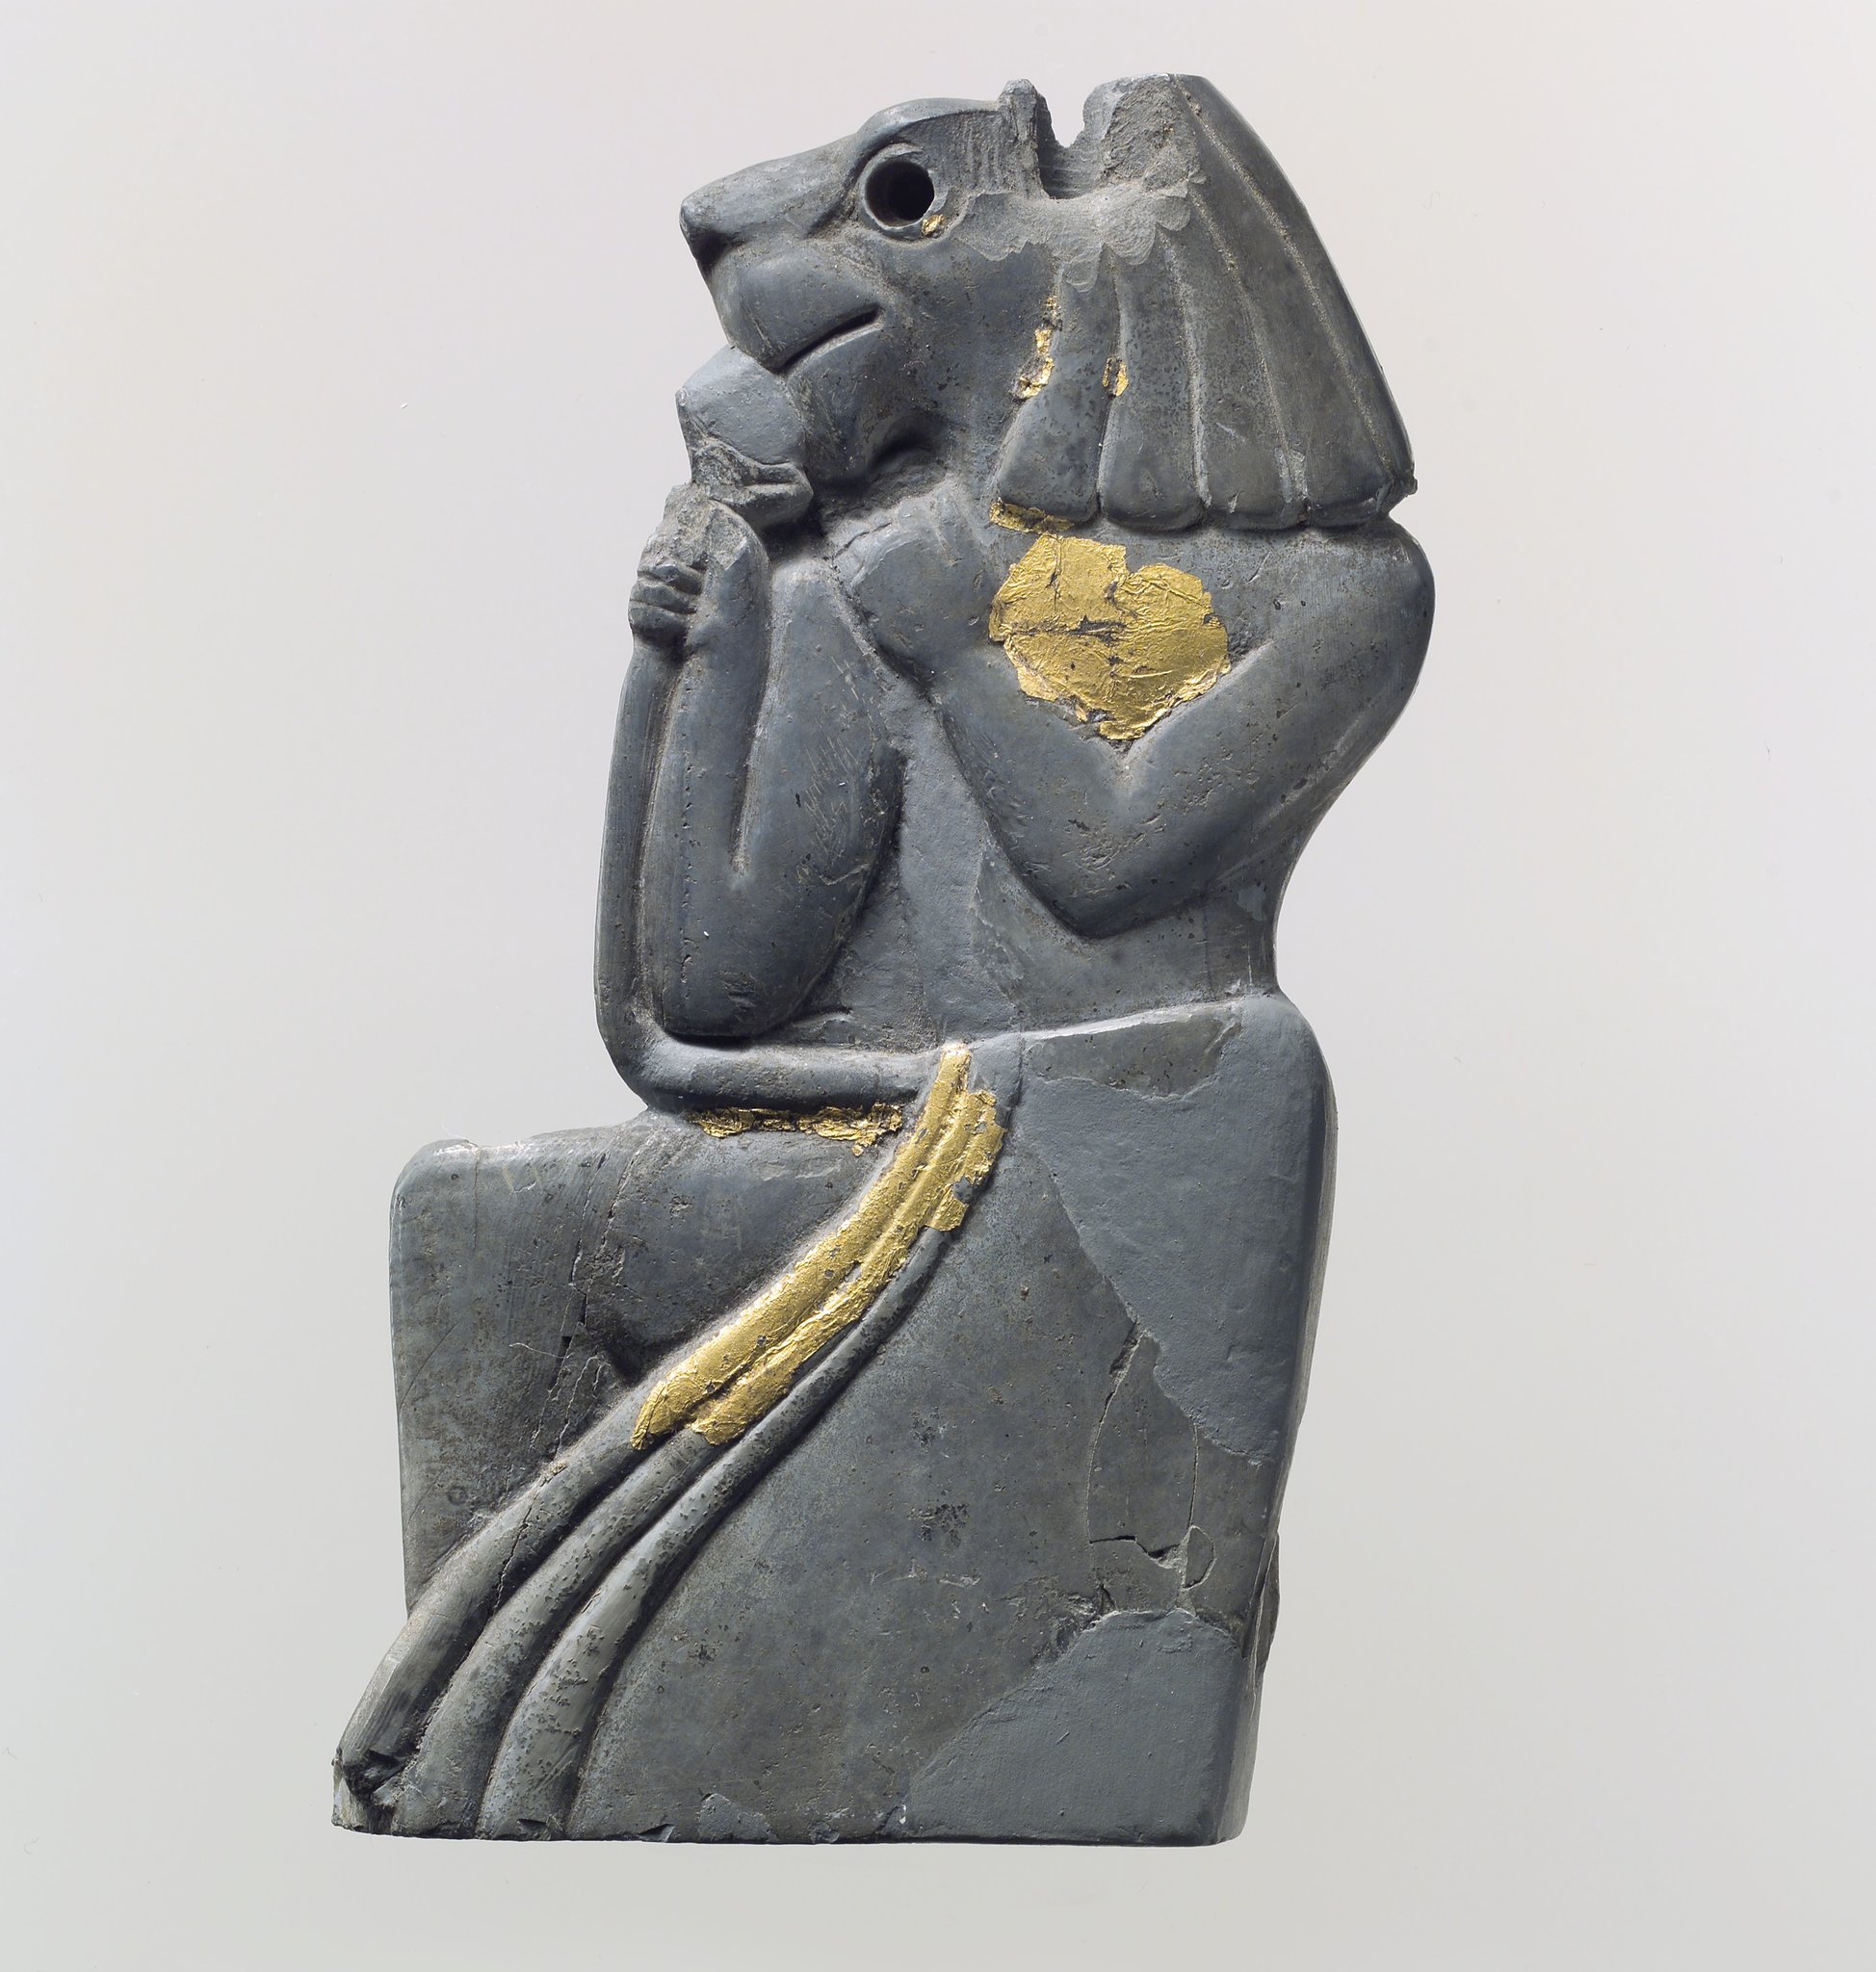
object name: relief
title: Plaque fragment: kneeling lion-headed figure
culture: assyrian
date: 1800-1701 BCE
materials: gold foil, ivory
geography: anatolia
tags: lions